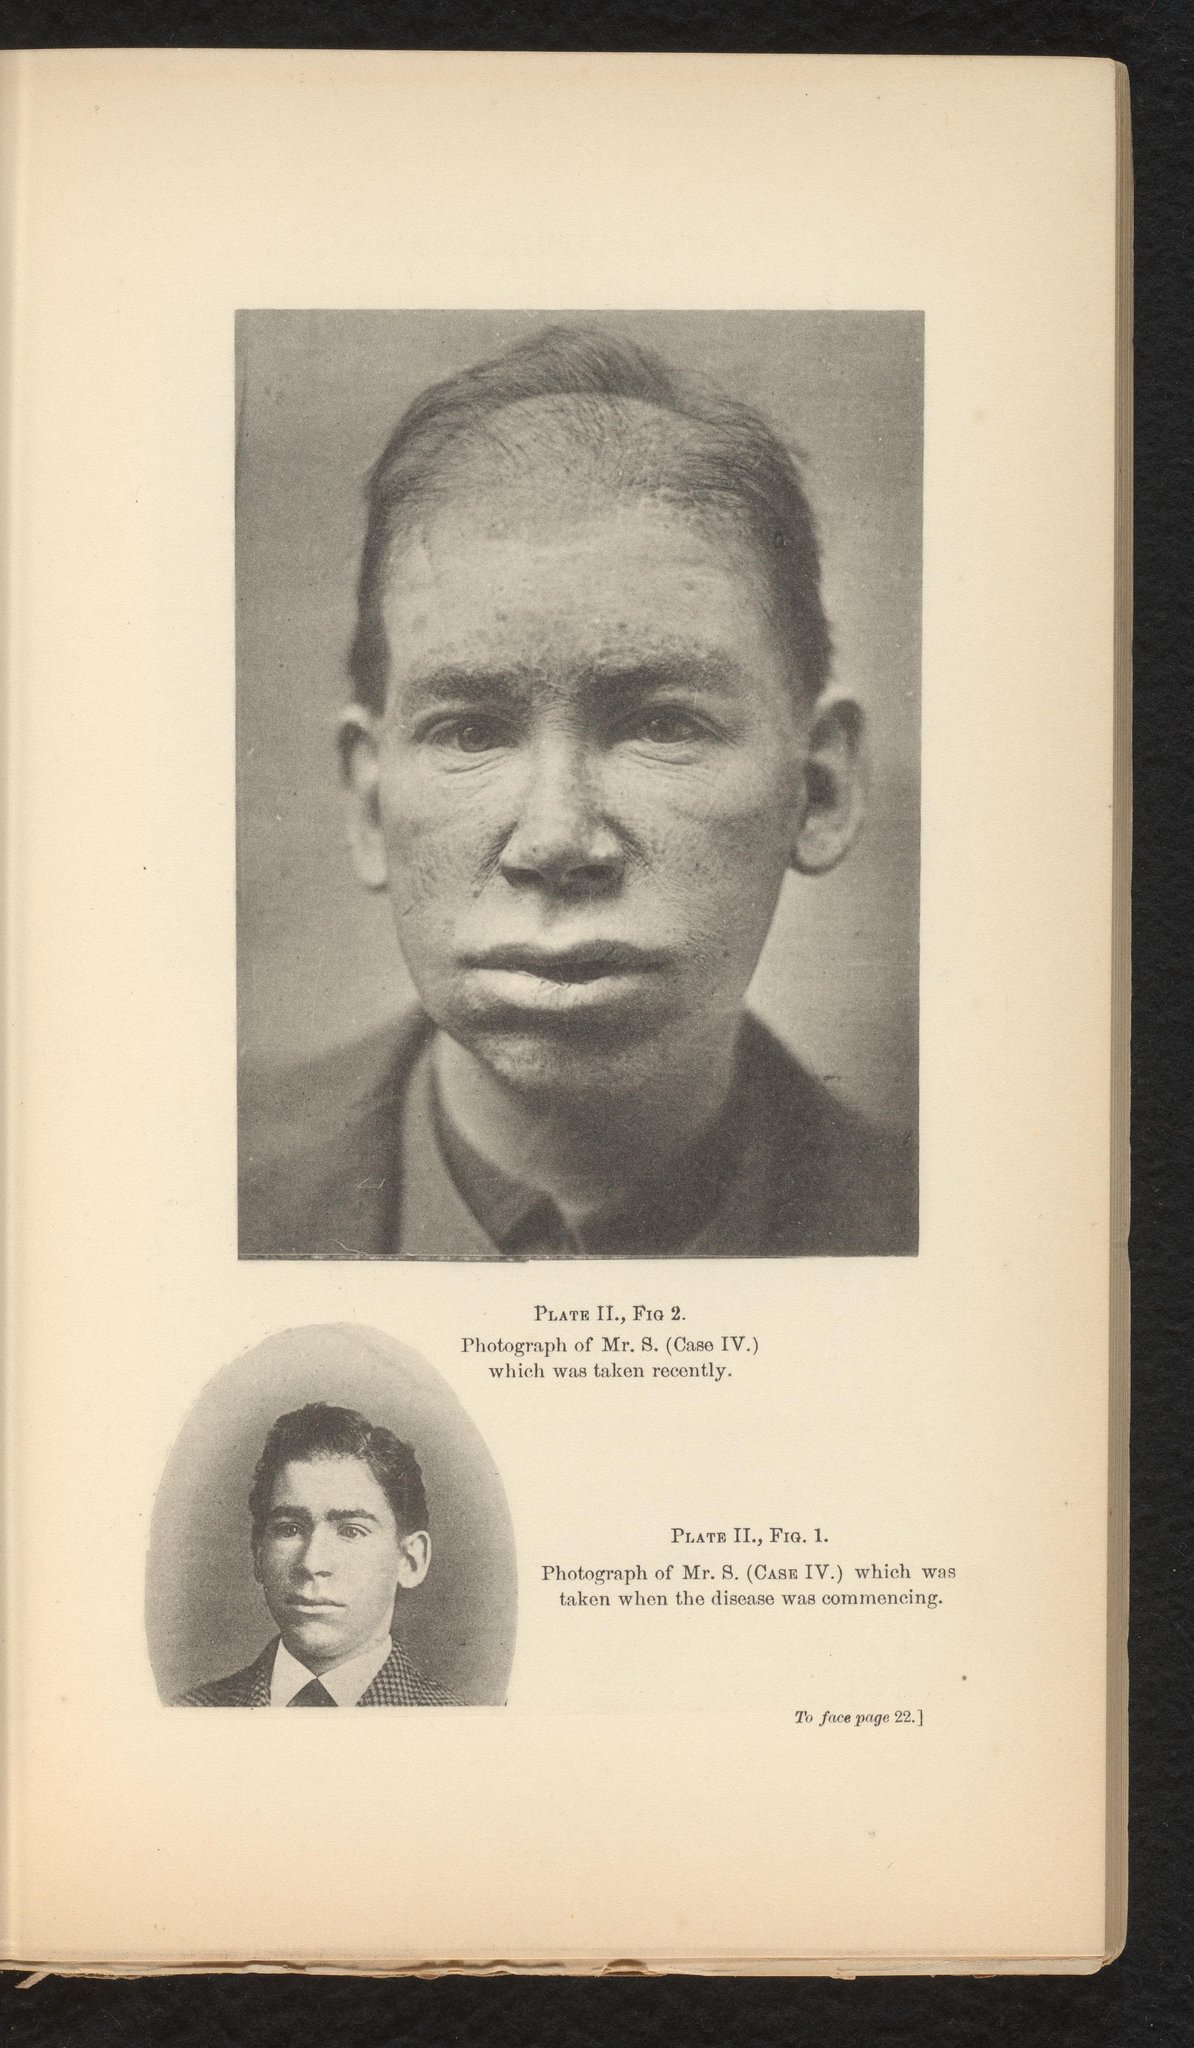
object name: page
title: Twee portretten van een onbekende man ter illustratie van myxoedeem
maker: Anonymous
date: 1883-1888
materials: linen, paper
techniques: photograph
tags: historical persons, diseases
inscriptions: inscription: ‘Plate II., Fig. 2./ Photograph of Mr. S. (Case IV.) which was taken recently’, inscription: ‘Plate II., Fig. 1./ Photograph of Mr. S. (Case IV.) which was taken when the disease was commencing’